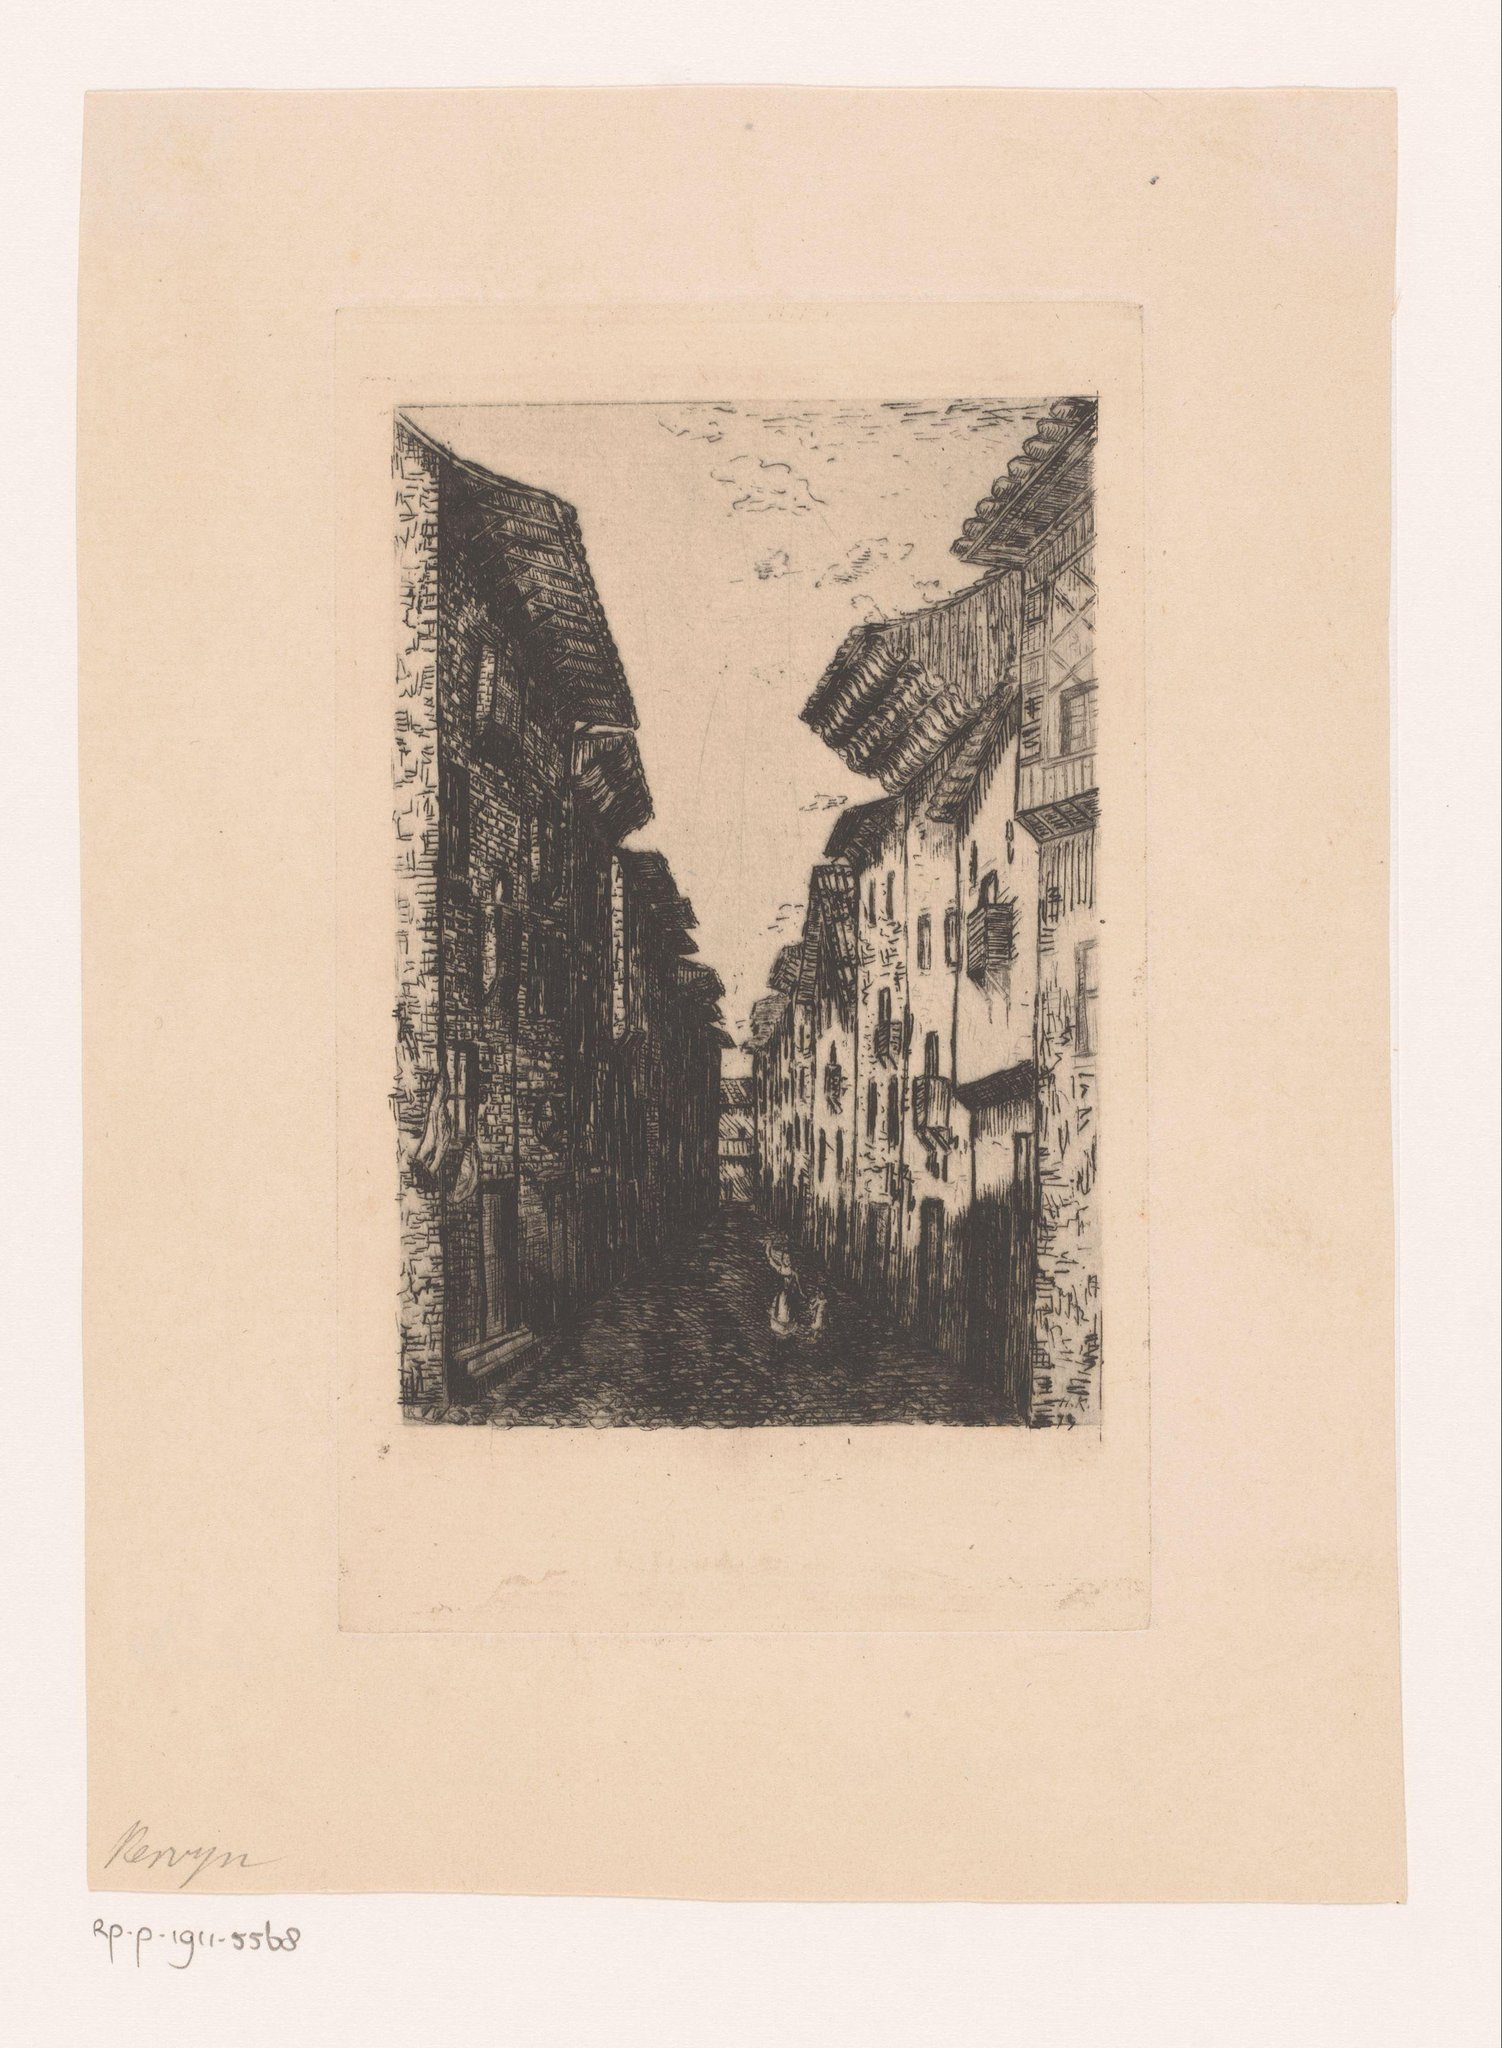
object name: print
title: Smalle straat met zwaaiende vrouw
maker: henri kervyn van lettenhove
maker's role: print maker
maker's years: 1856-1928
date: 1879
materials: paper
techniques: drypoint, etching, intaglio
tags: street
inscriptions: collector's mark: Lugt 2228